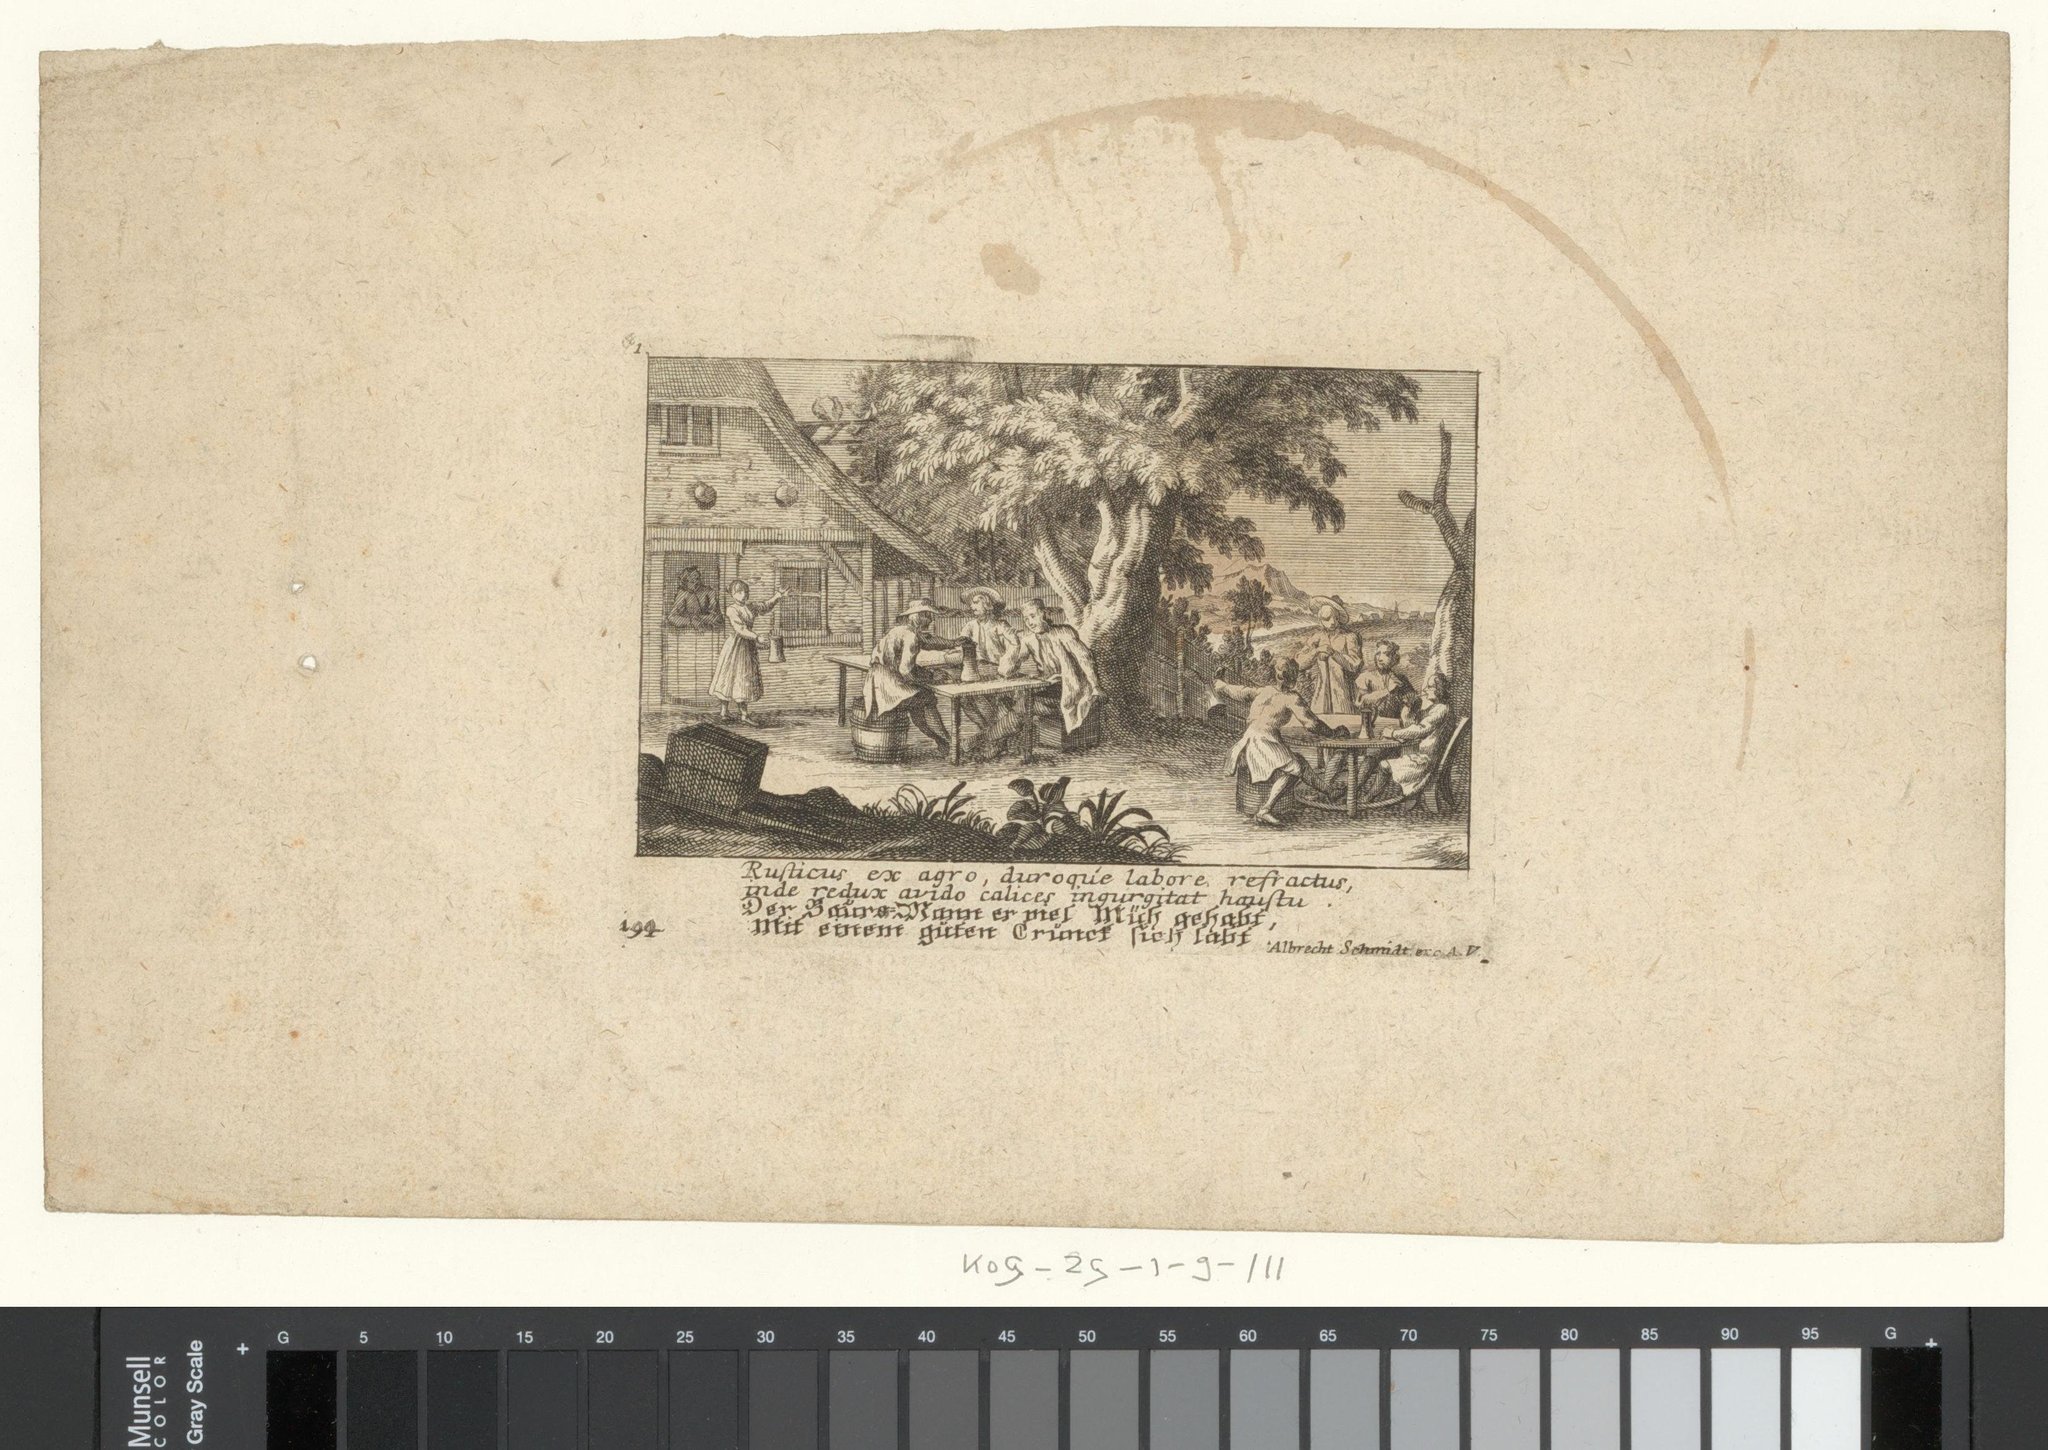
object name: print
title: Boeren voor een herberg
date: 1694-1744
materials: paper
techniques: engraving, etching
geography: augsburg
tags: drinking, hotel, hostelry, inn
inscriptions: collector's mark: Lugt 1641, stamp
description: Onderaan vier regels tekst in het Frans en Duits. Linksboven genummerd: 1. Linksonder gesigneerd: 194. Onderwerpsrubrieken binnen de Atlas Zeden en Gewoonten: Handel, nijverheid en verkeer, Boerenleven.